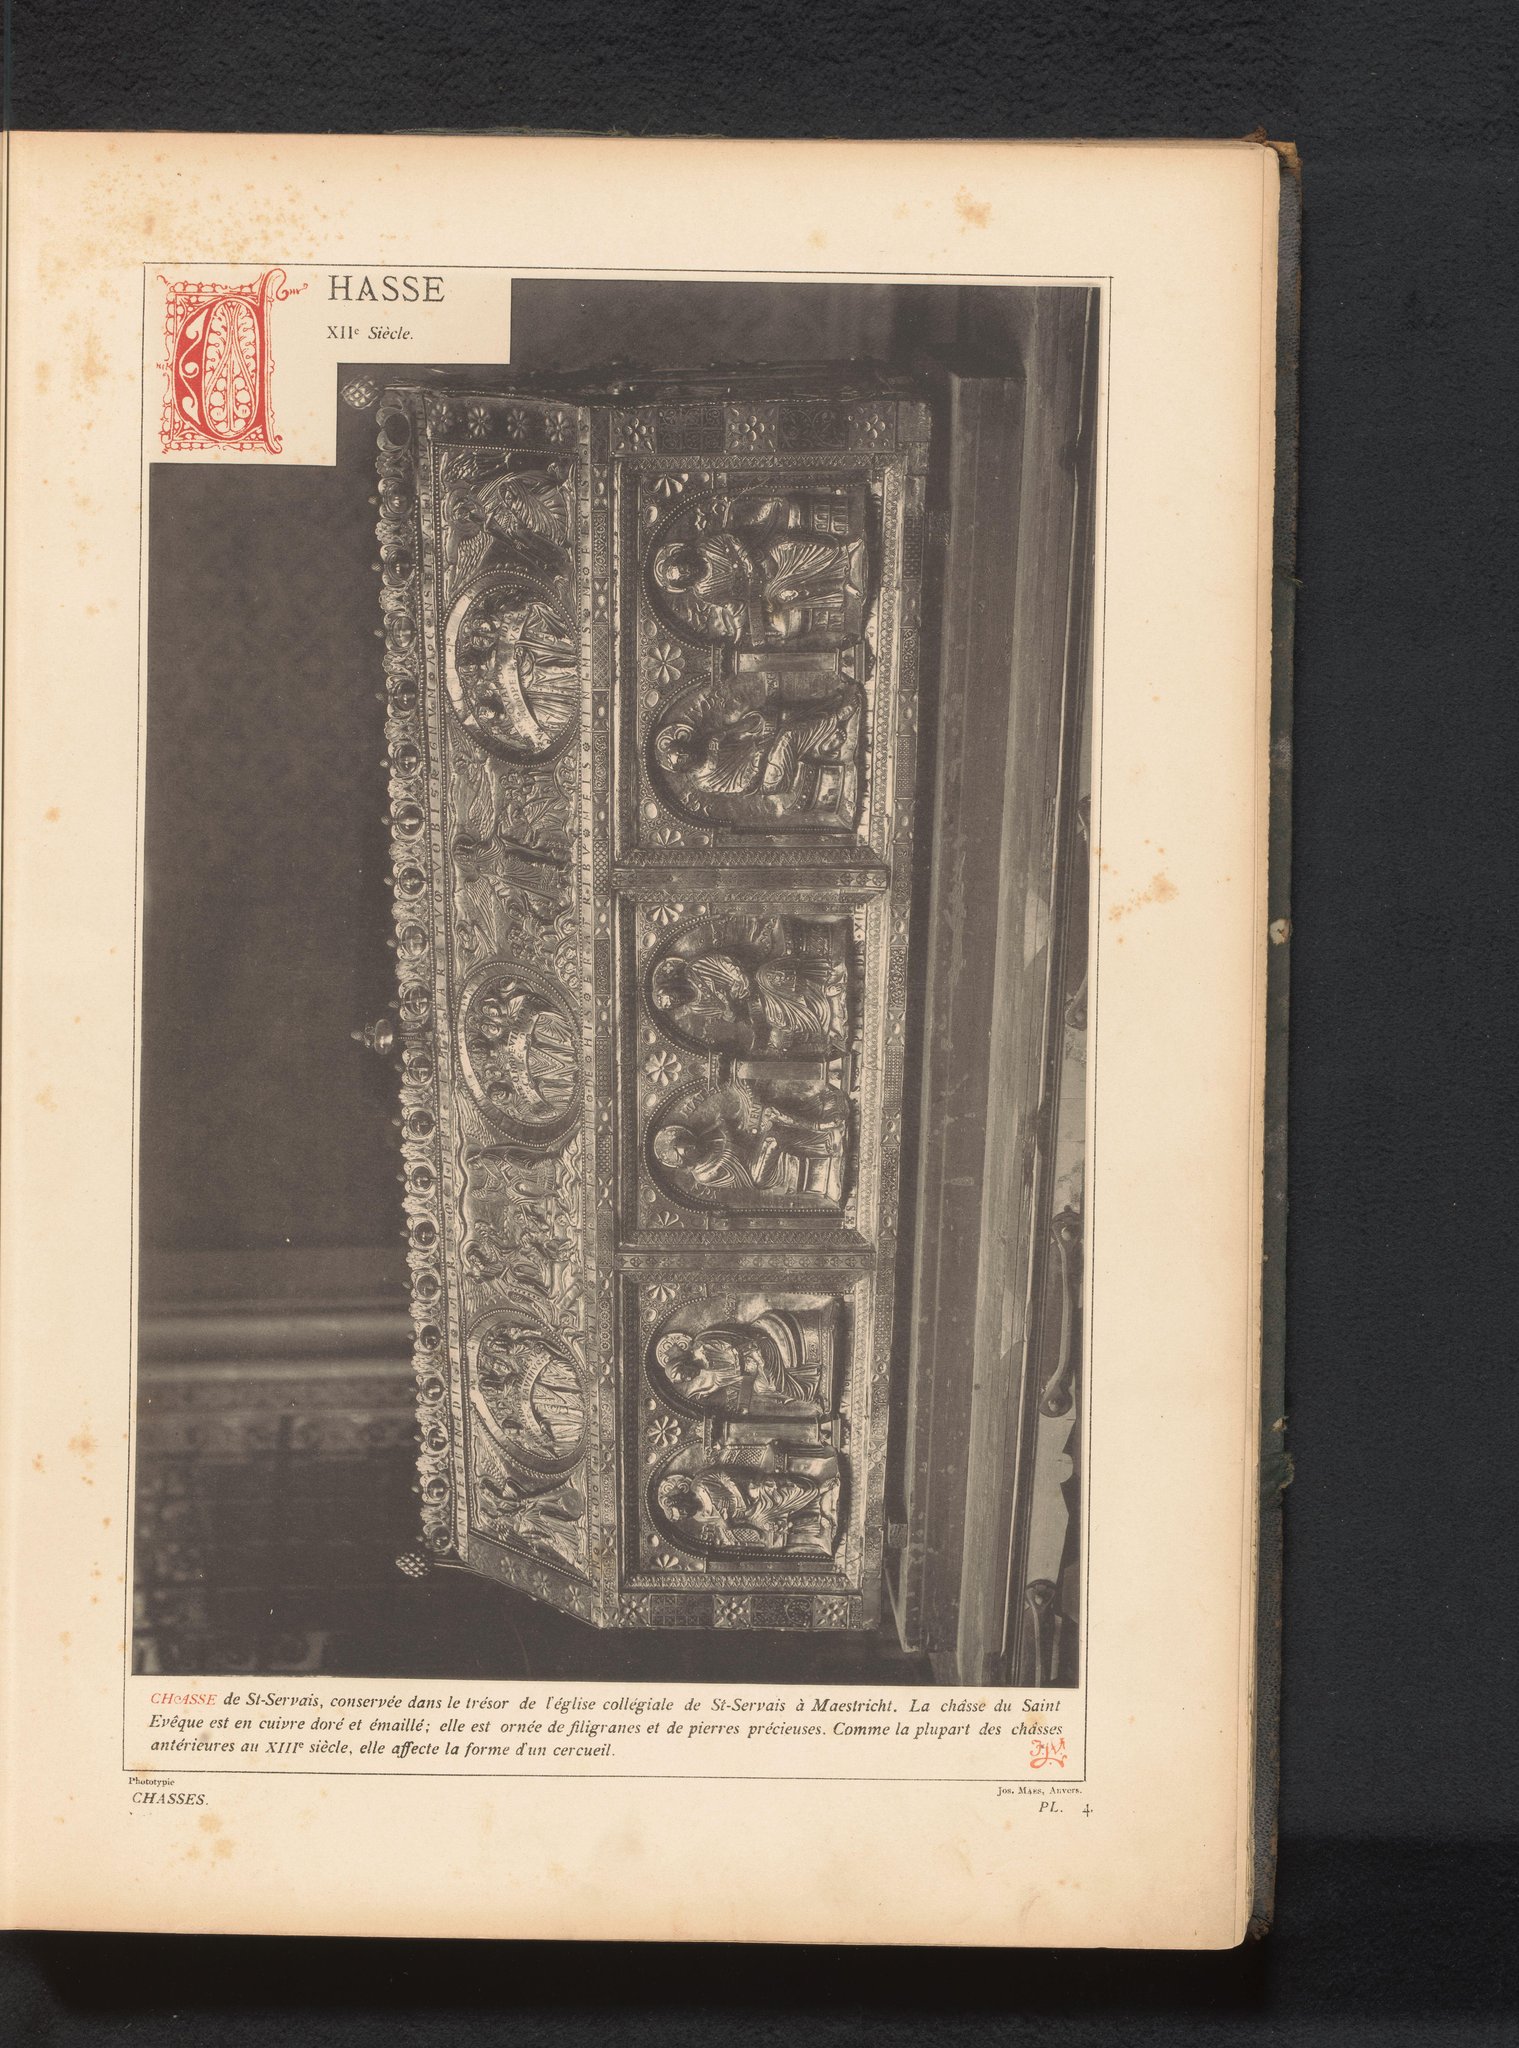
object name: photomechanical print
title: Relikwieënkast van de heilige Servaas in de Sint-Servaasbasiliek in Maastricht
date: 1882-1887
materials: paper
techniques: photograph, photolithography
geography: antwerp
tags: relics (and reliquaries)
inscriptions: inscription: ‘CHASSES. - PL. 4.’, monogram: ‘JJvY’, inscription: ‘CHASSE de St-Servais (...)’